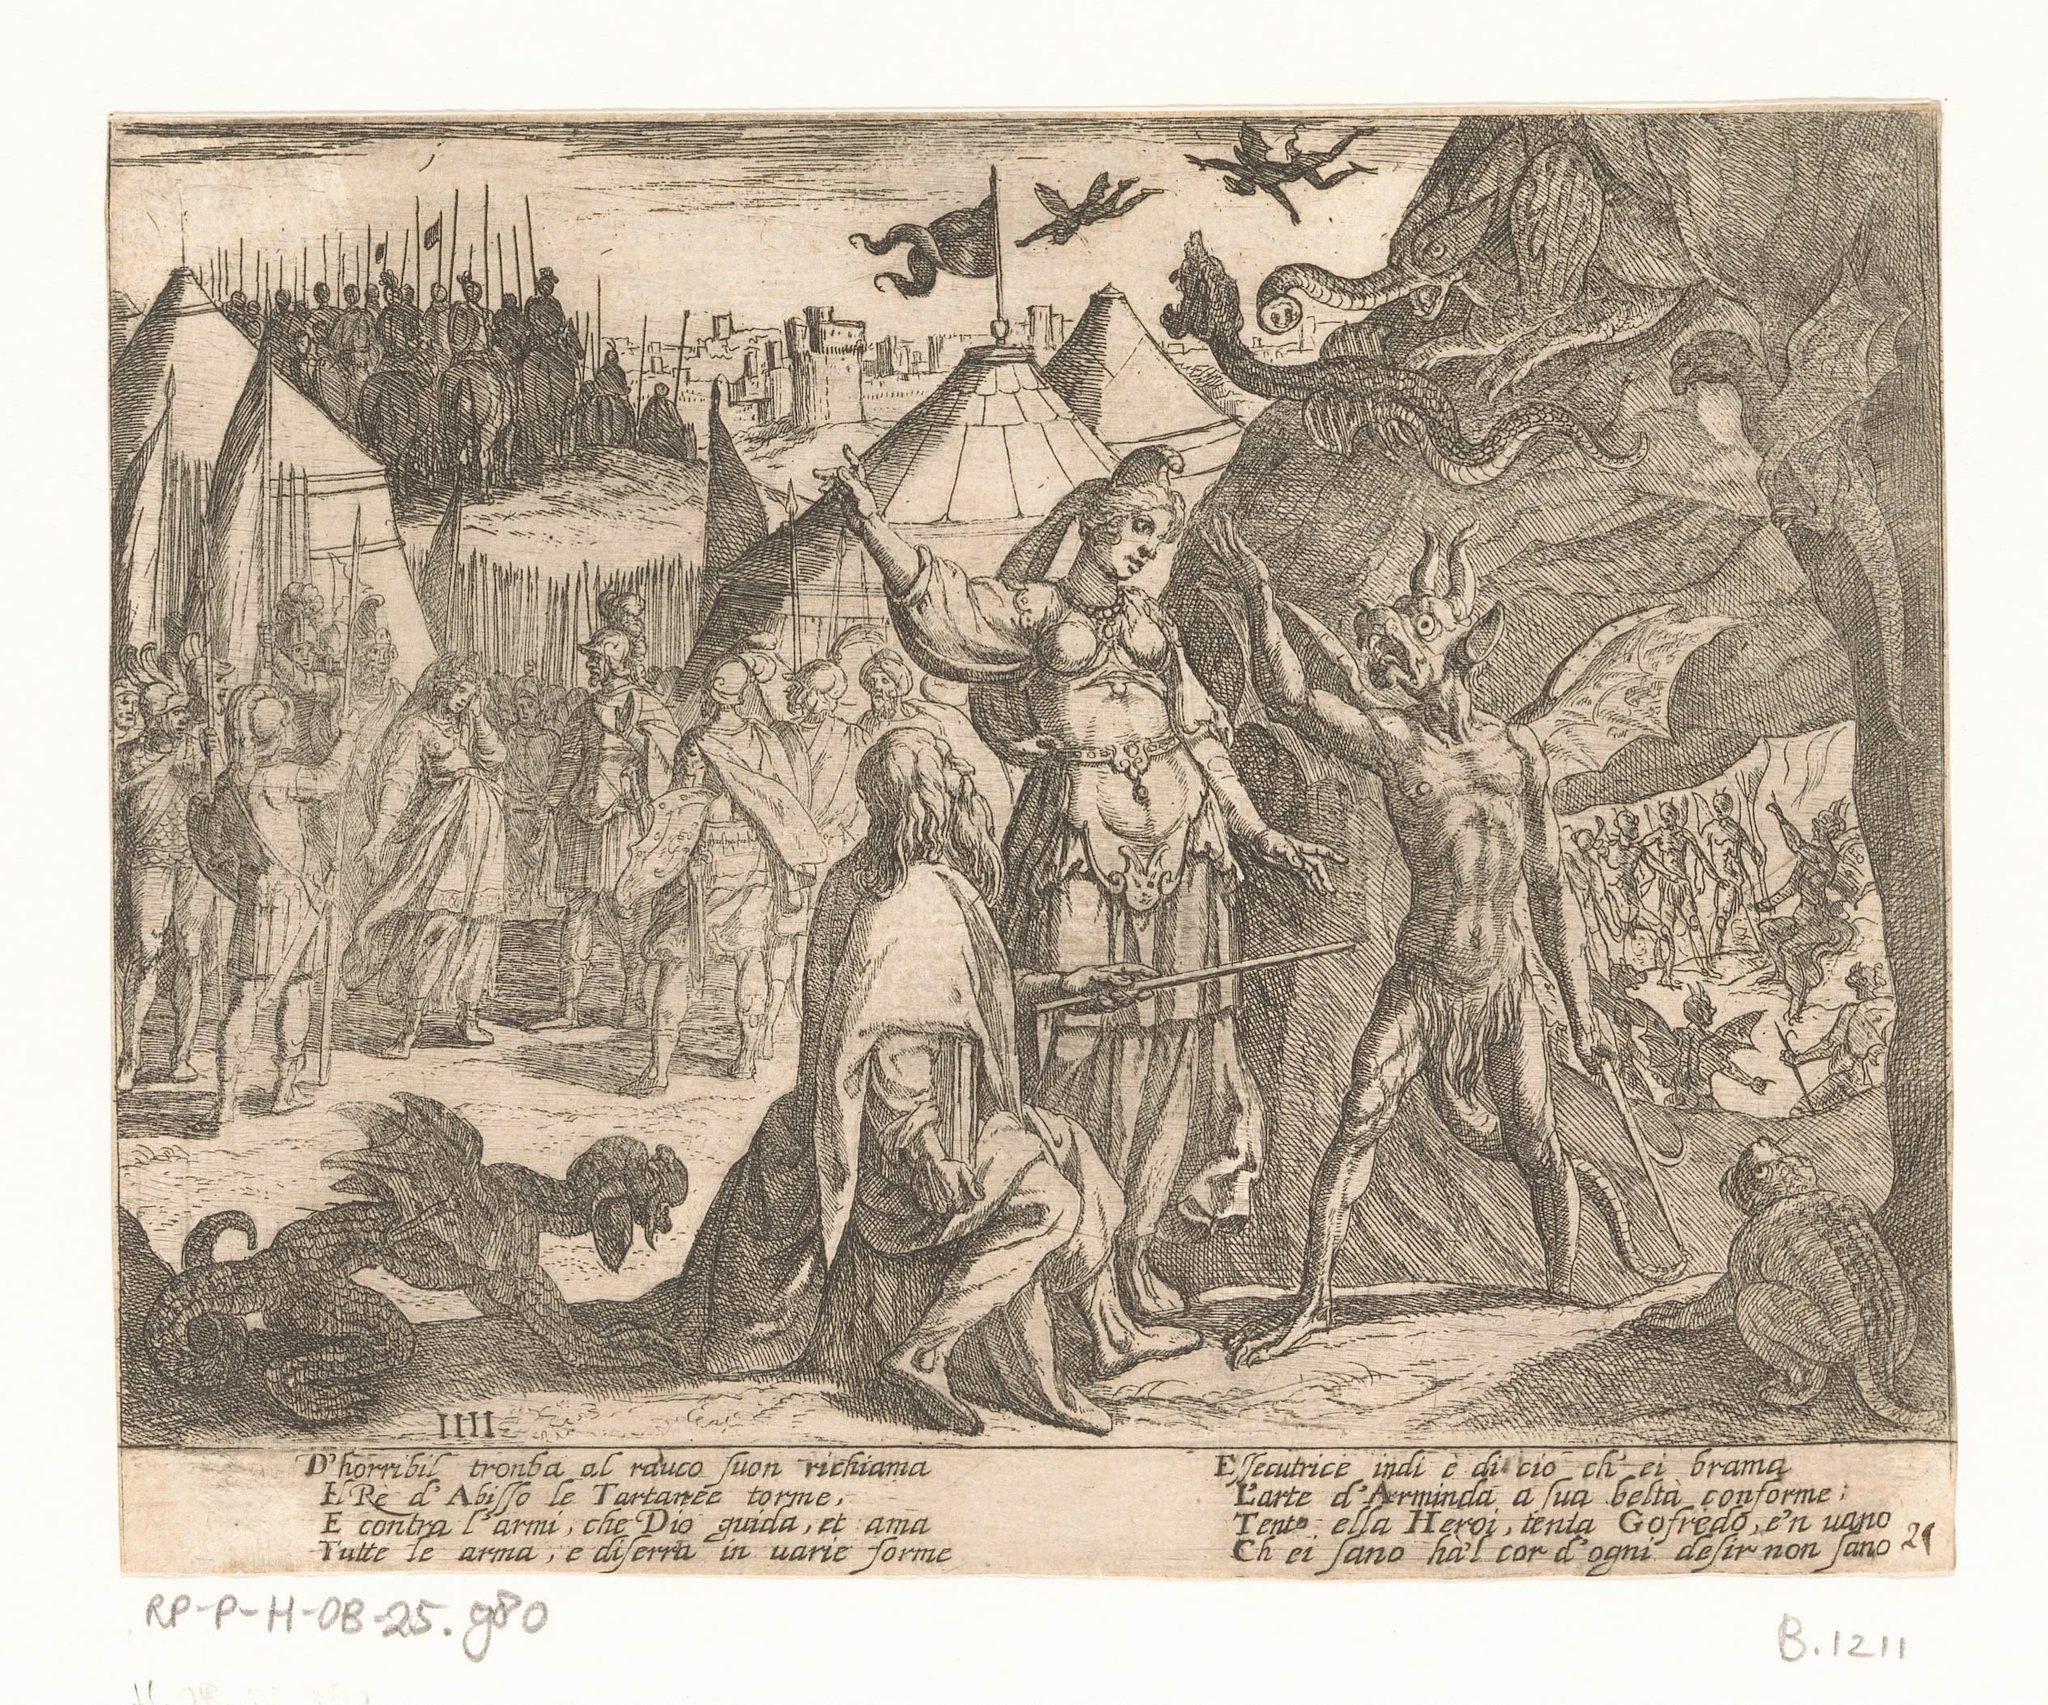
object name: print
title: Illustratie bij Canto IV van Tasso's 'Gerusalemme Liberata'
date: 1565-1630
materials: paper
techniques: etching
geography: italy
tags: devil(s) and demons: satan, militant proselytizing: religious war, crusade, etc., (scenes from) specific works of literature: tasso, gerusalemme liberata, knight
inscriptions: collector's mark: Lugt 11, collector's mark: ‘Hinloopen’, number: ‘21’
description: Deze prent maakt deel uit van een reeks van twintig prenten (+ opdracht) met voorstellingen van scènes uit Tasso's 'Jeruzalem verlost', een episch gedicht geschreven door de Italiaanse dichter Torquato Tasso en voor het eerst gepubliceerd in 1581. Het verhaal vertelt grotendeels in fictie over de Eerste Kruistocht waarin de christenen, geleid door Godfried van Bouillon, de strijd aangaan met de moslims om het Beleg van Jeruzalem.